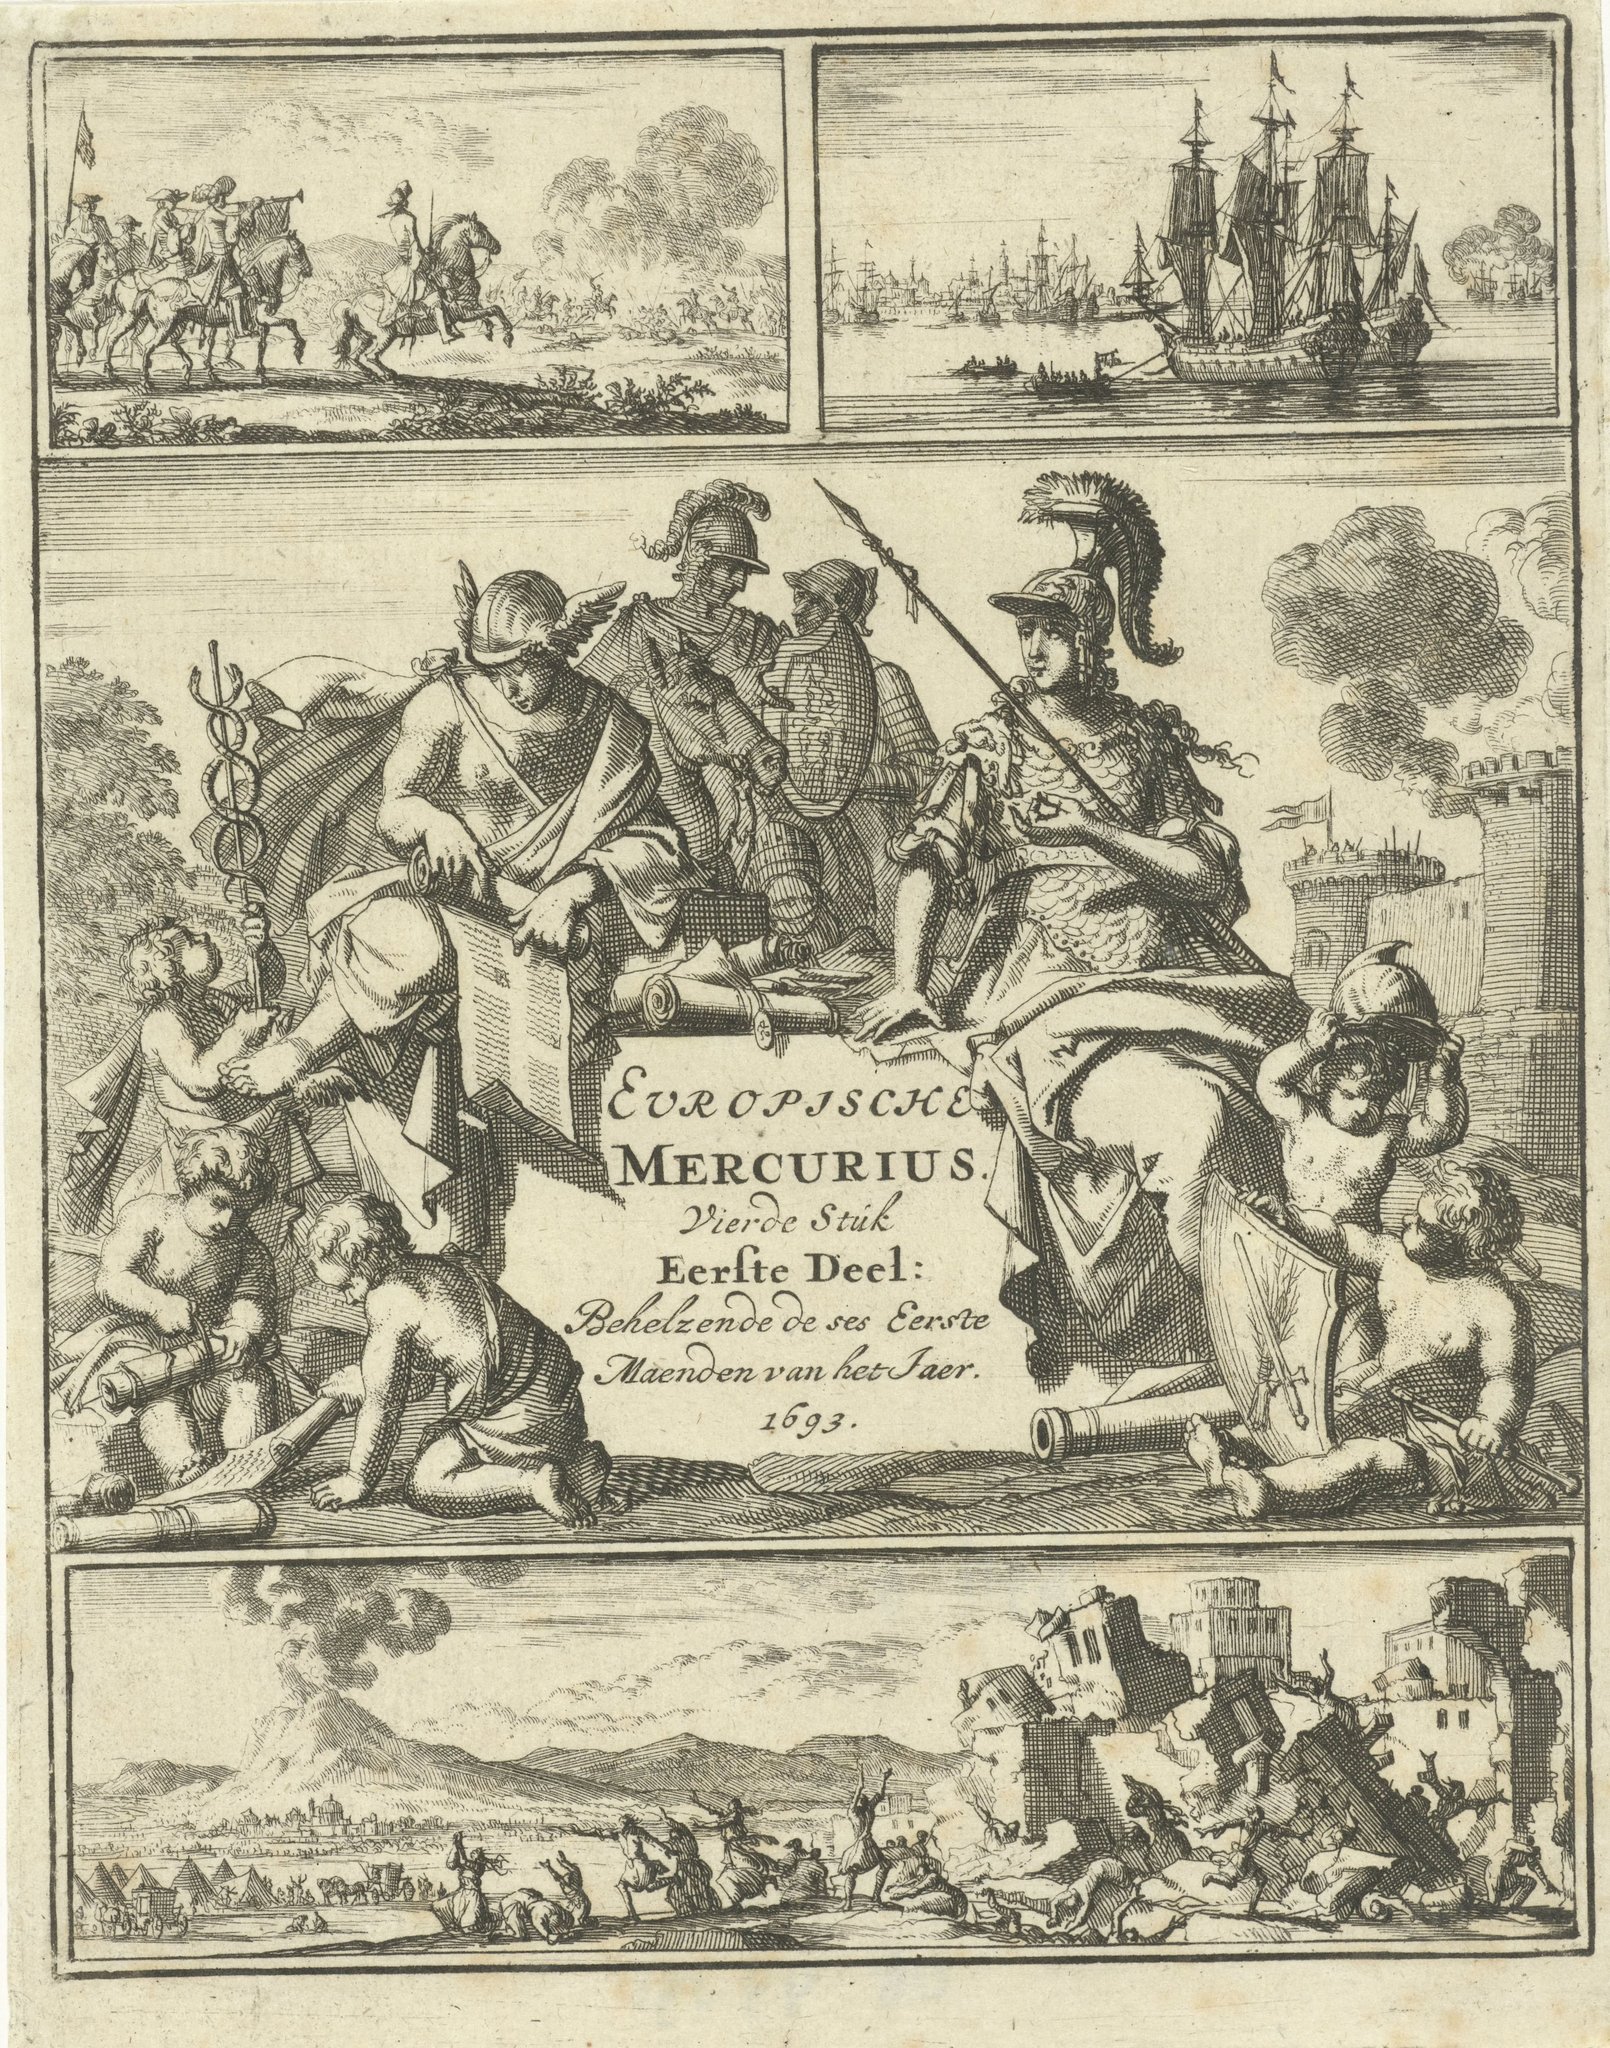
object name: titelblad, titelpagina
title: Titelpagina voor: Europische Mercurius, Vierde Stuk, Eerste Deel: Behelzende de ses Eerste Maenden van het Jaer 1693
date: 1693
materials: paper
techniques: etching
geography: amsterdam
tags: (story of) minerva (pallas, athena), (story of) mercury (hermes), battle, ships (in general) - cc - more than one ship, earthquake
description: Titelpagina voor: Europische Mercurius, behelzende al het voornaamste 'tgeen, zo omtrent de zaaken van staat als oorlog (...) is voorgevallen (...). Vierde Stuk, begrypende (...) het jaar 1693. Amsterdam: Timotheus ten Hoorn, 1693.